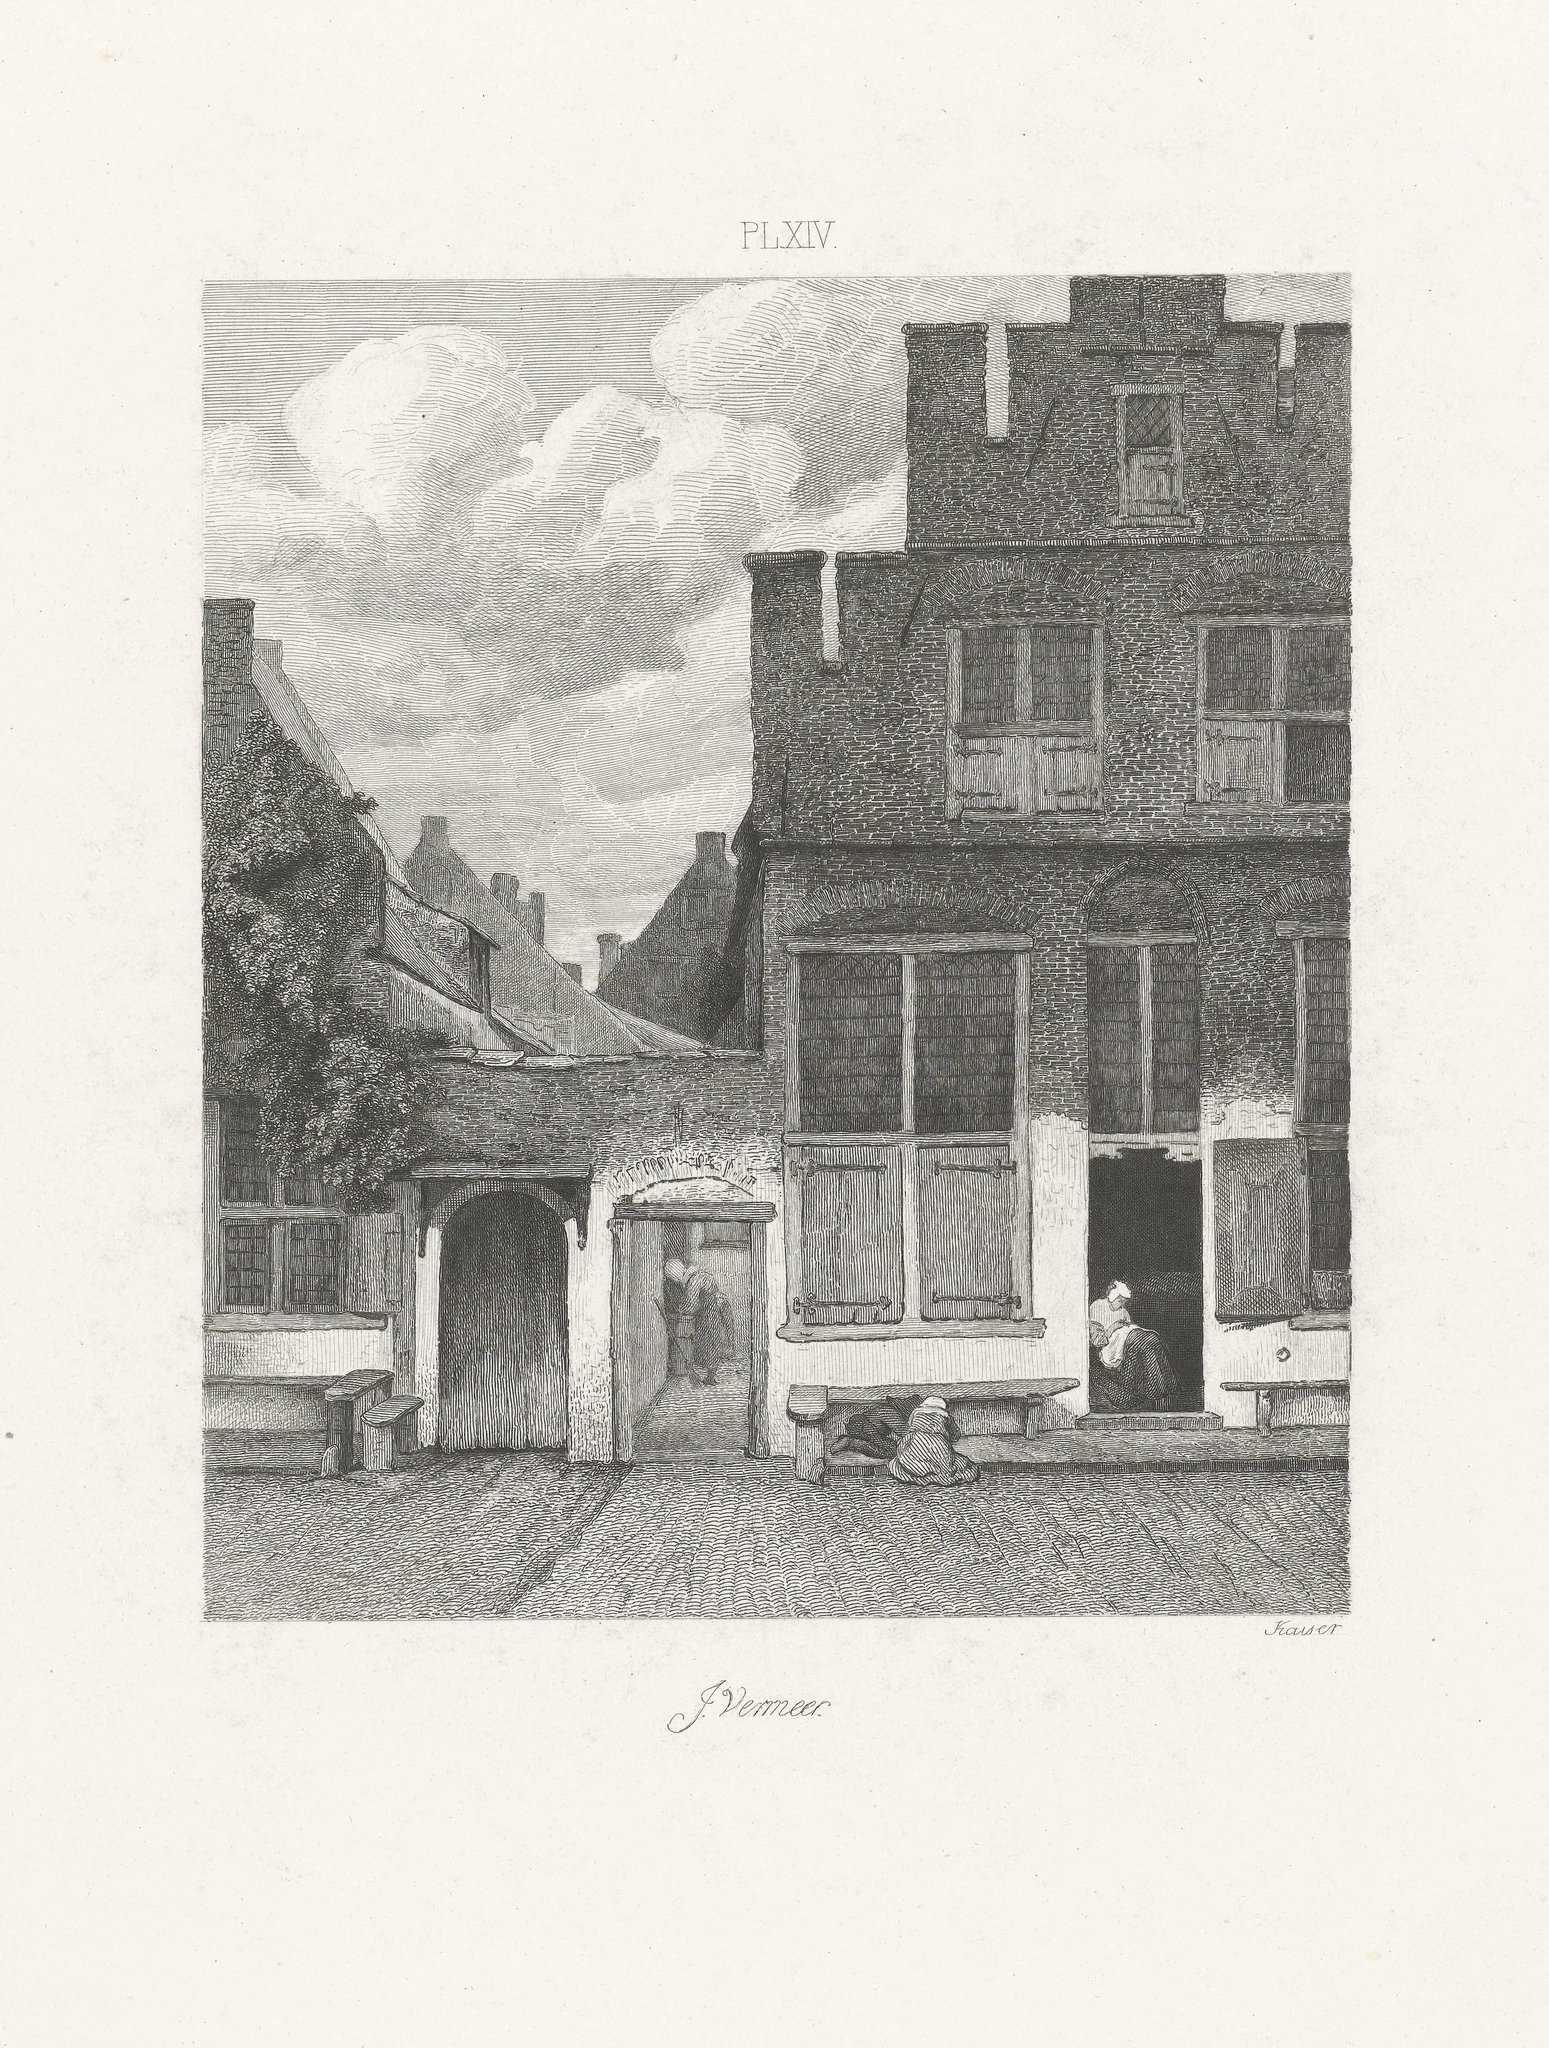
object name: print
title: Hollandse meesters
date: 1823-1900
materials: paper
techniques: etching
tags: delft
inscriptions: collector's mark: Lugt 2228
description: De gevels van enkele huizen aan een straat in Delft. Tussen de huizen een steegje waar een vrouw over een wastobbe gebogen staat. In de openstaande deur van het huis rechts zit een vrouw te handwerken, links voor het huis op de stoep twee spelende kinderen. Deze prent maakt deel uit van een serie van 25 prenten naar Hollandse meesters. Boven de afbeelding: PL XIV.